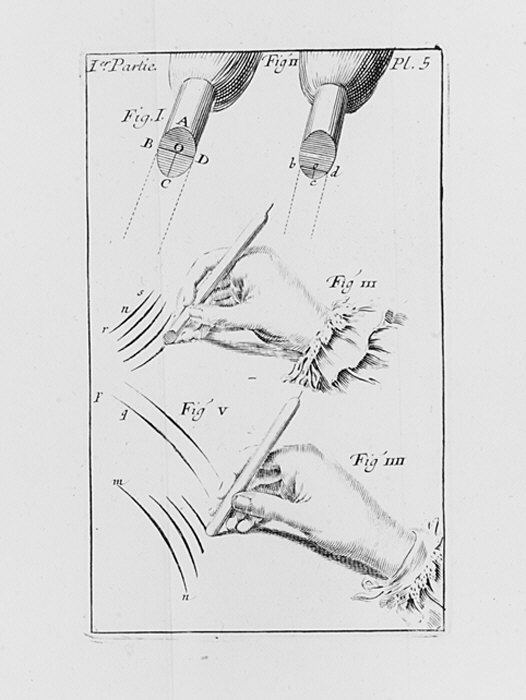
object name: book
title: De la maniere de graver a l'eauforte et au burin, et de la gravure in maniere noire. . .Nouvelle édition augmentée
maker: abraham bosse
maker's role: artist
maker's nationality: french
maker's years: 1602-1676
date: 1758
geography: france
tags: hands,writing implements